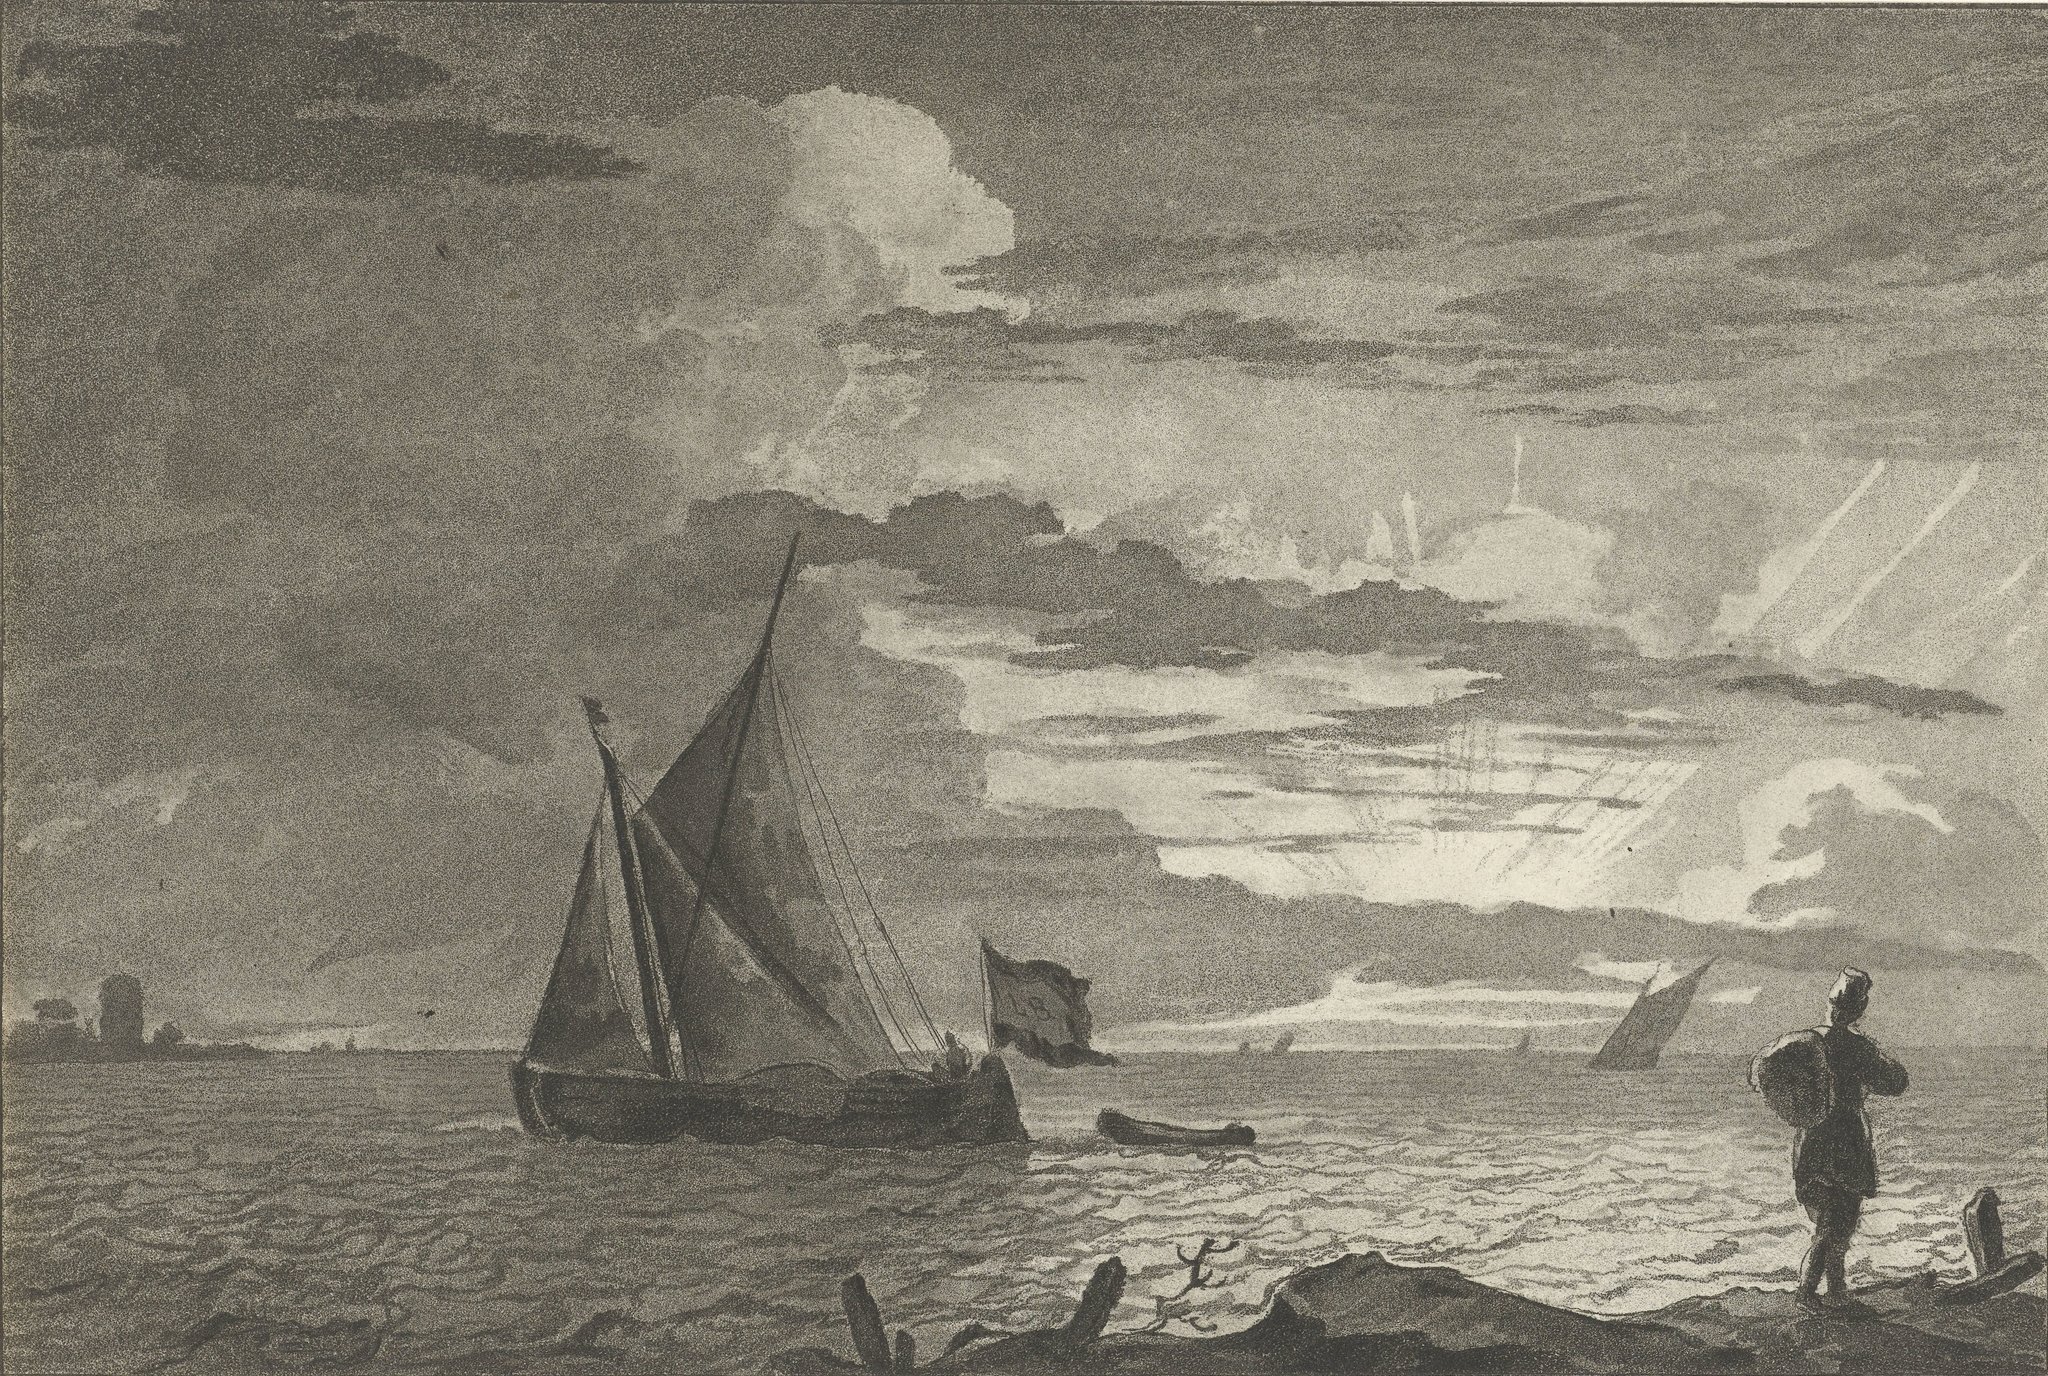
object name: print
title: Man met zak op de schouder bij zonsopgang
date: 1781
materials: paper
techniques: etching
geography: amsterdam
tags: sailing-ship, sailing-boat, sunrise, carrying something on the head or on the shoulders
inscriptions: inscription: ‘L. Bakhuizen del. Ploos van MAstel. J.C. Fecit. 1781.’, collector's mark: Lugt 2725, collector's mark: Lugt 240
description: Rechts op de voorgrond een man met een zak op de schouder kijkend naar de schepen en de zonsopgang.